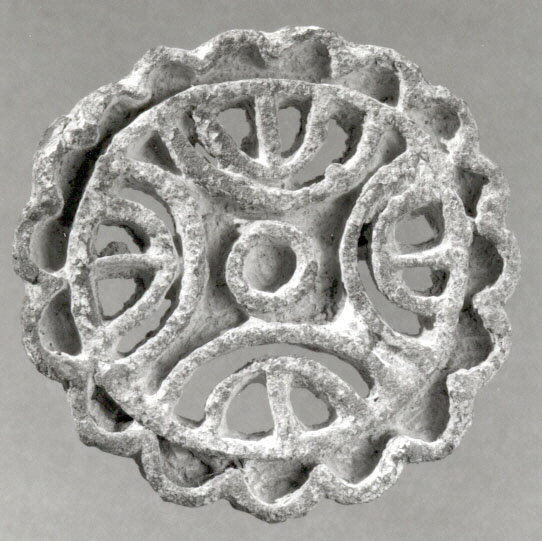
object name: stamp seal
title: Compartmented stamp seal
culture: bactria-margiana archaeological complex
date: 2333-1668 BCE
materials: copper alloy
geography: bactria-margiana